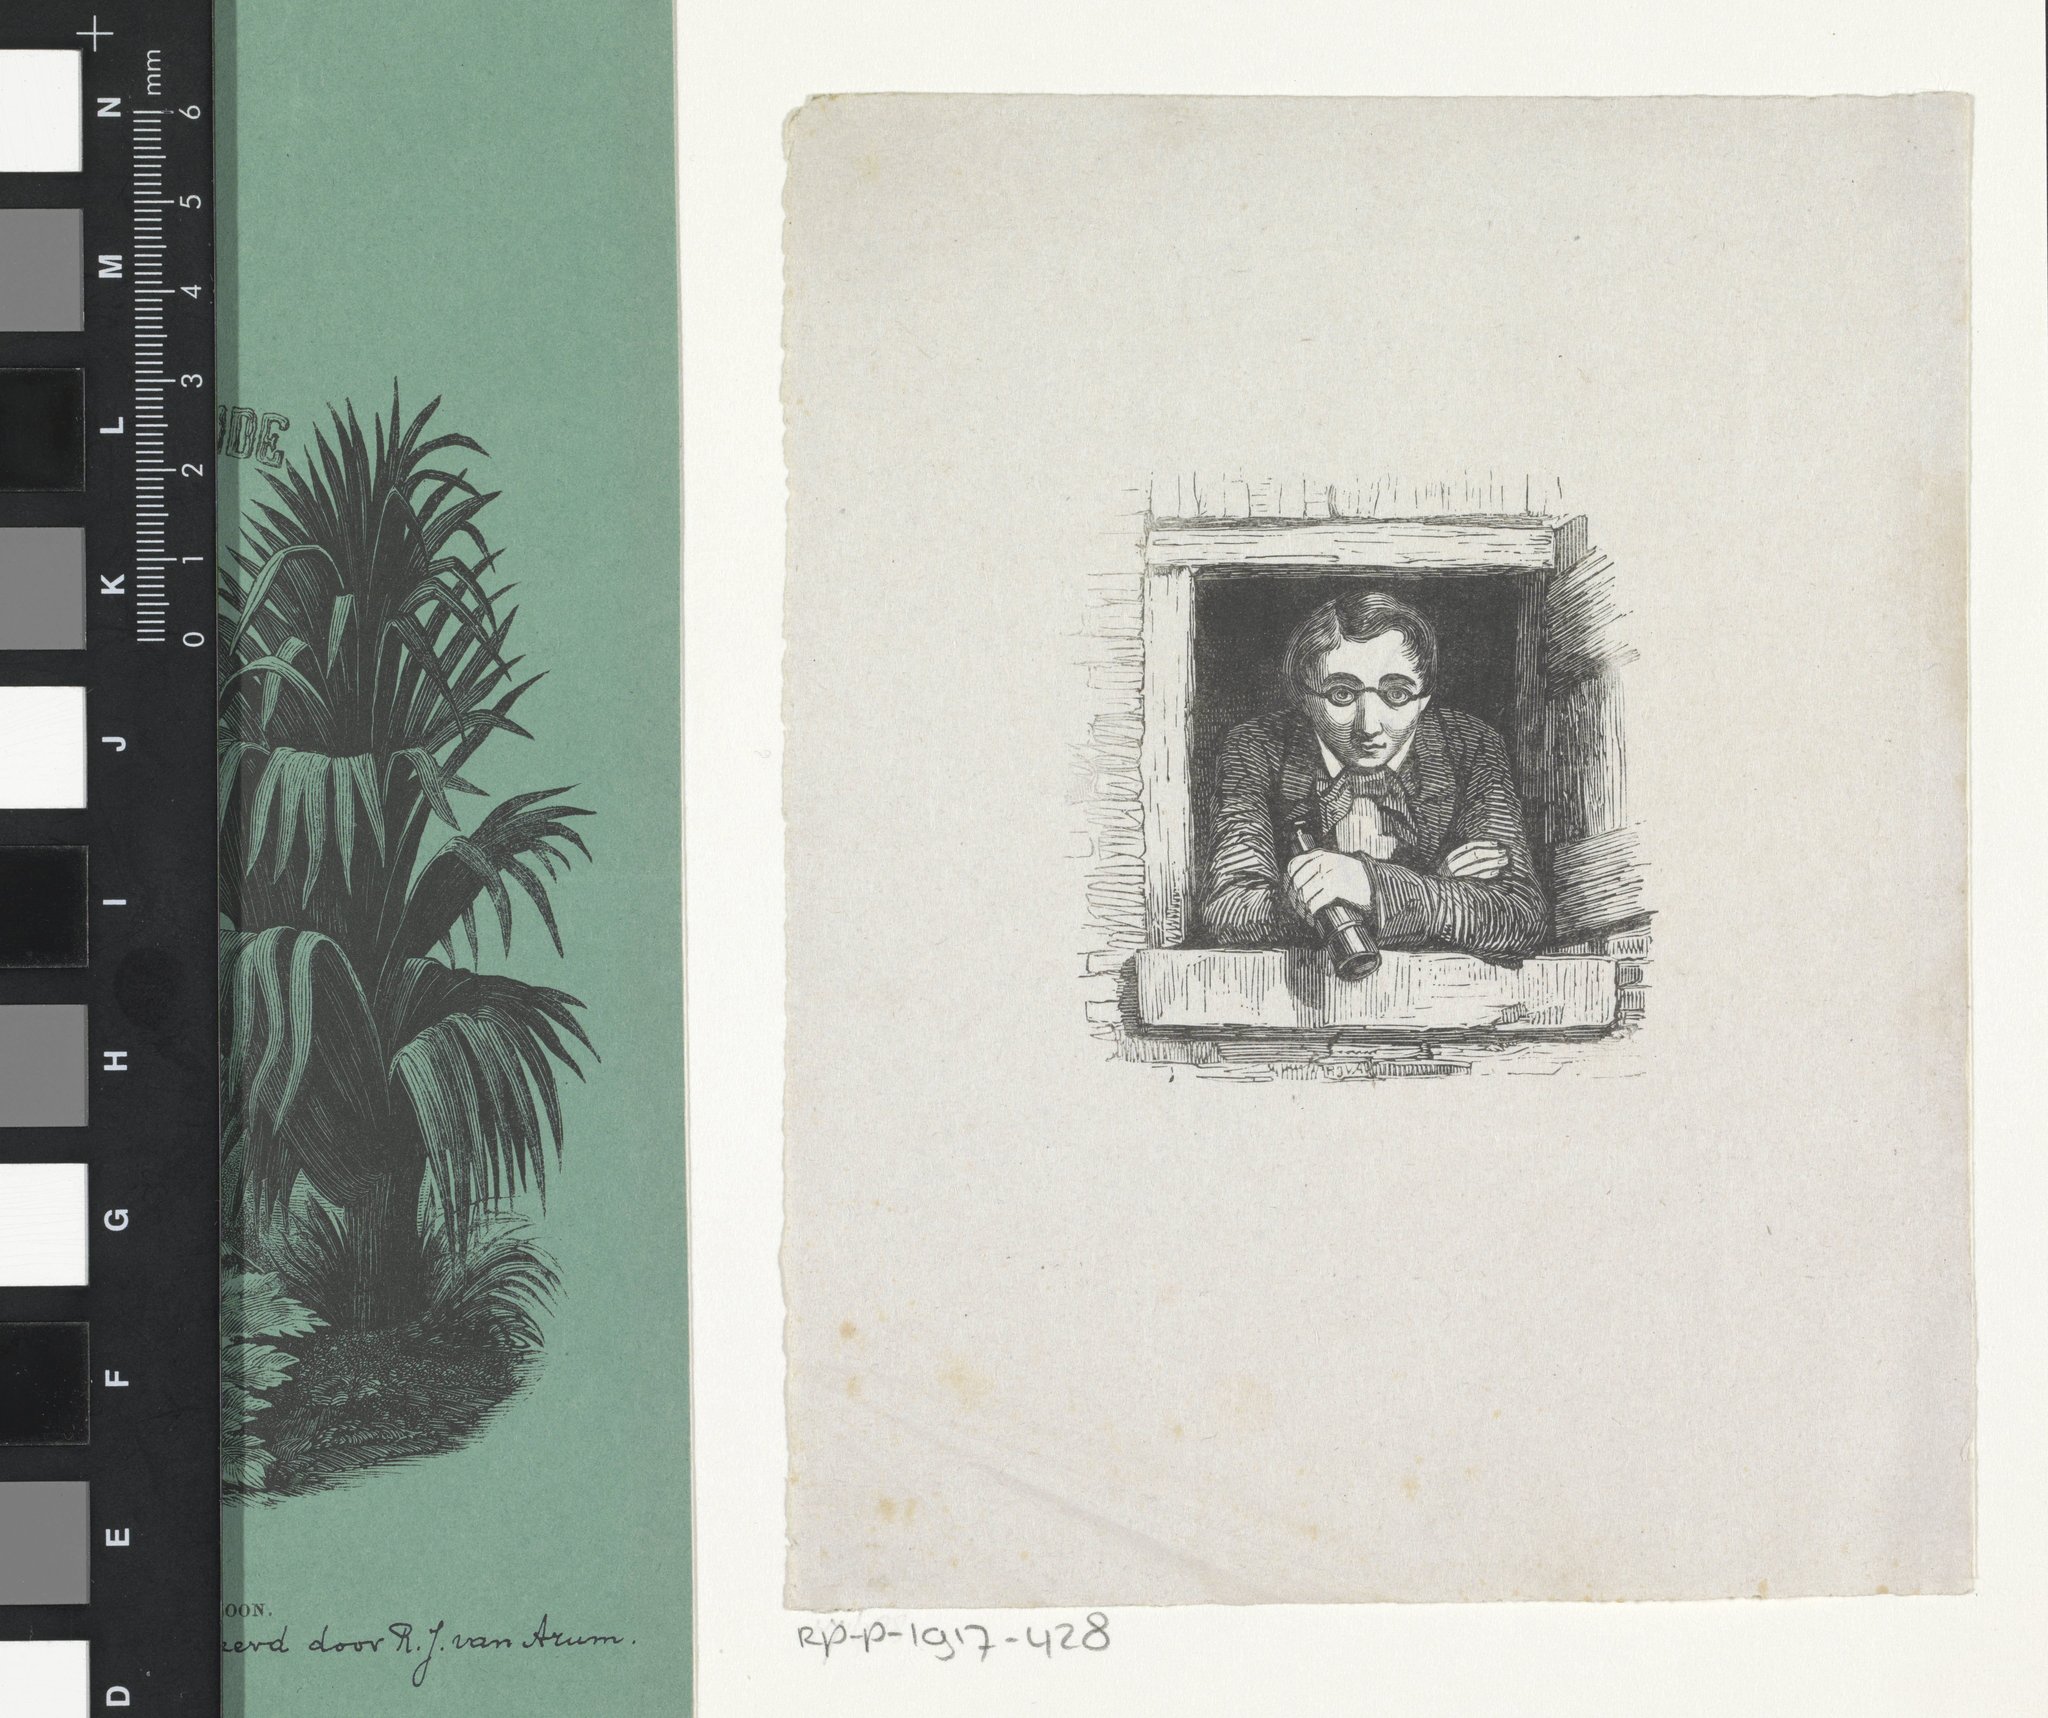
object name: print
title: Man leunt met een monoculair uit een venster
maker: rombertus julianus van arum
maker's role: print maker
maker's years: 1812-1883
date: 1822-1883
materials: paper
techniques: engraving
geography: amsterdam